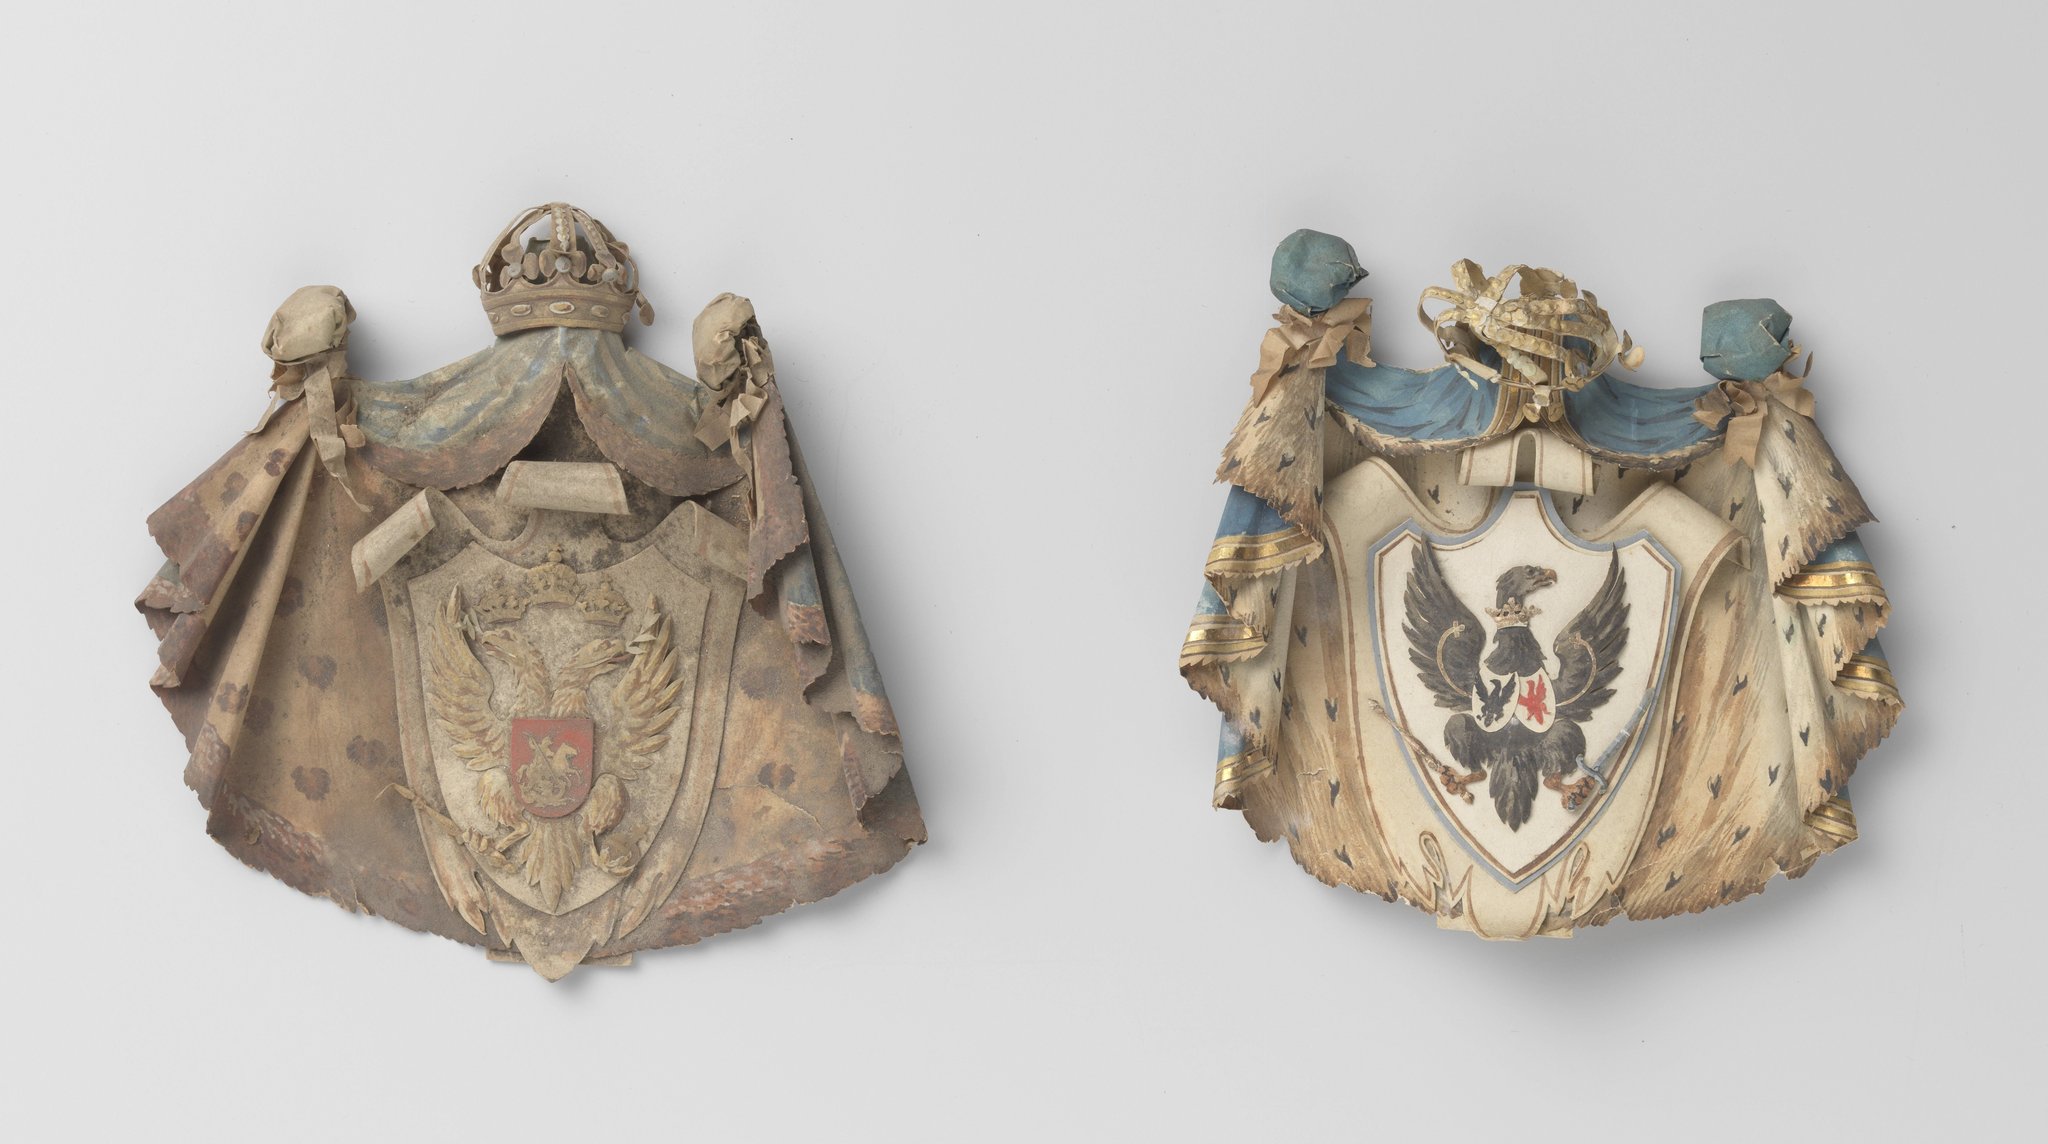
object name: memorial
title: Zinnebeeldige tempel des Vredes, ter herinnering aan de vrede van 1814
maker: johannes hubertus reygers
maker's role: print maker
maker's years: 1767-1849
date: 1814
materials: cardboard, paper, wood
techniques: cutting, snipping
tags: paris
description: Opstelling van houten en papieren onderdelen die samen een tempel vormen ter viering van de Vrede van Parijs (1814).